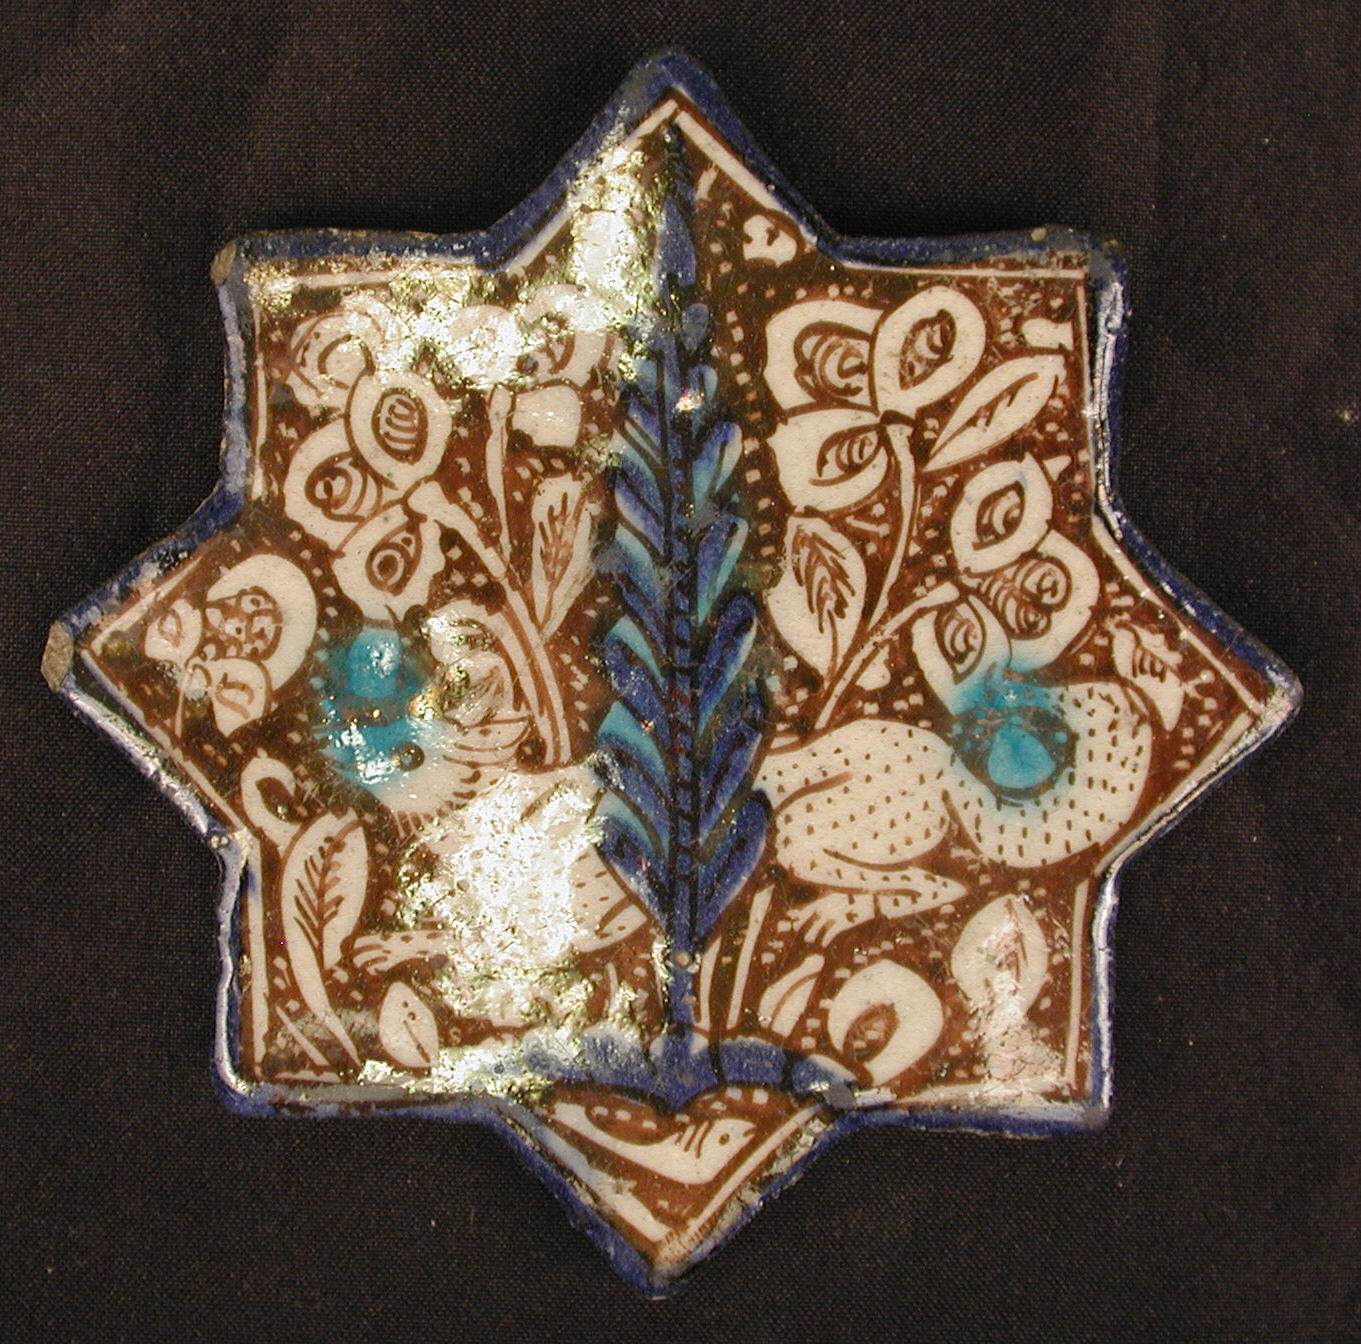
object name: tile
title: Star-Shaped Tile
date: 1267-1333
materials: stonepaste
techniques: luster painting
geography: iran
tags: animals,leaves